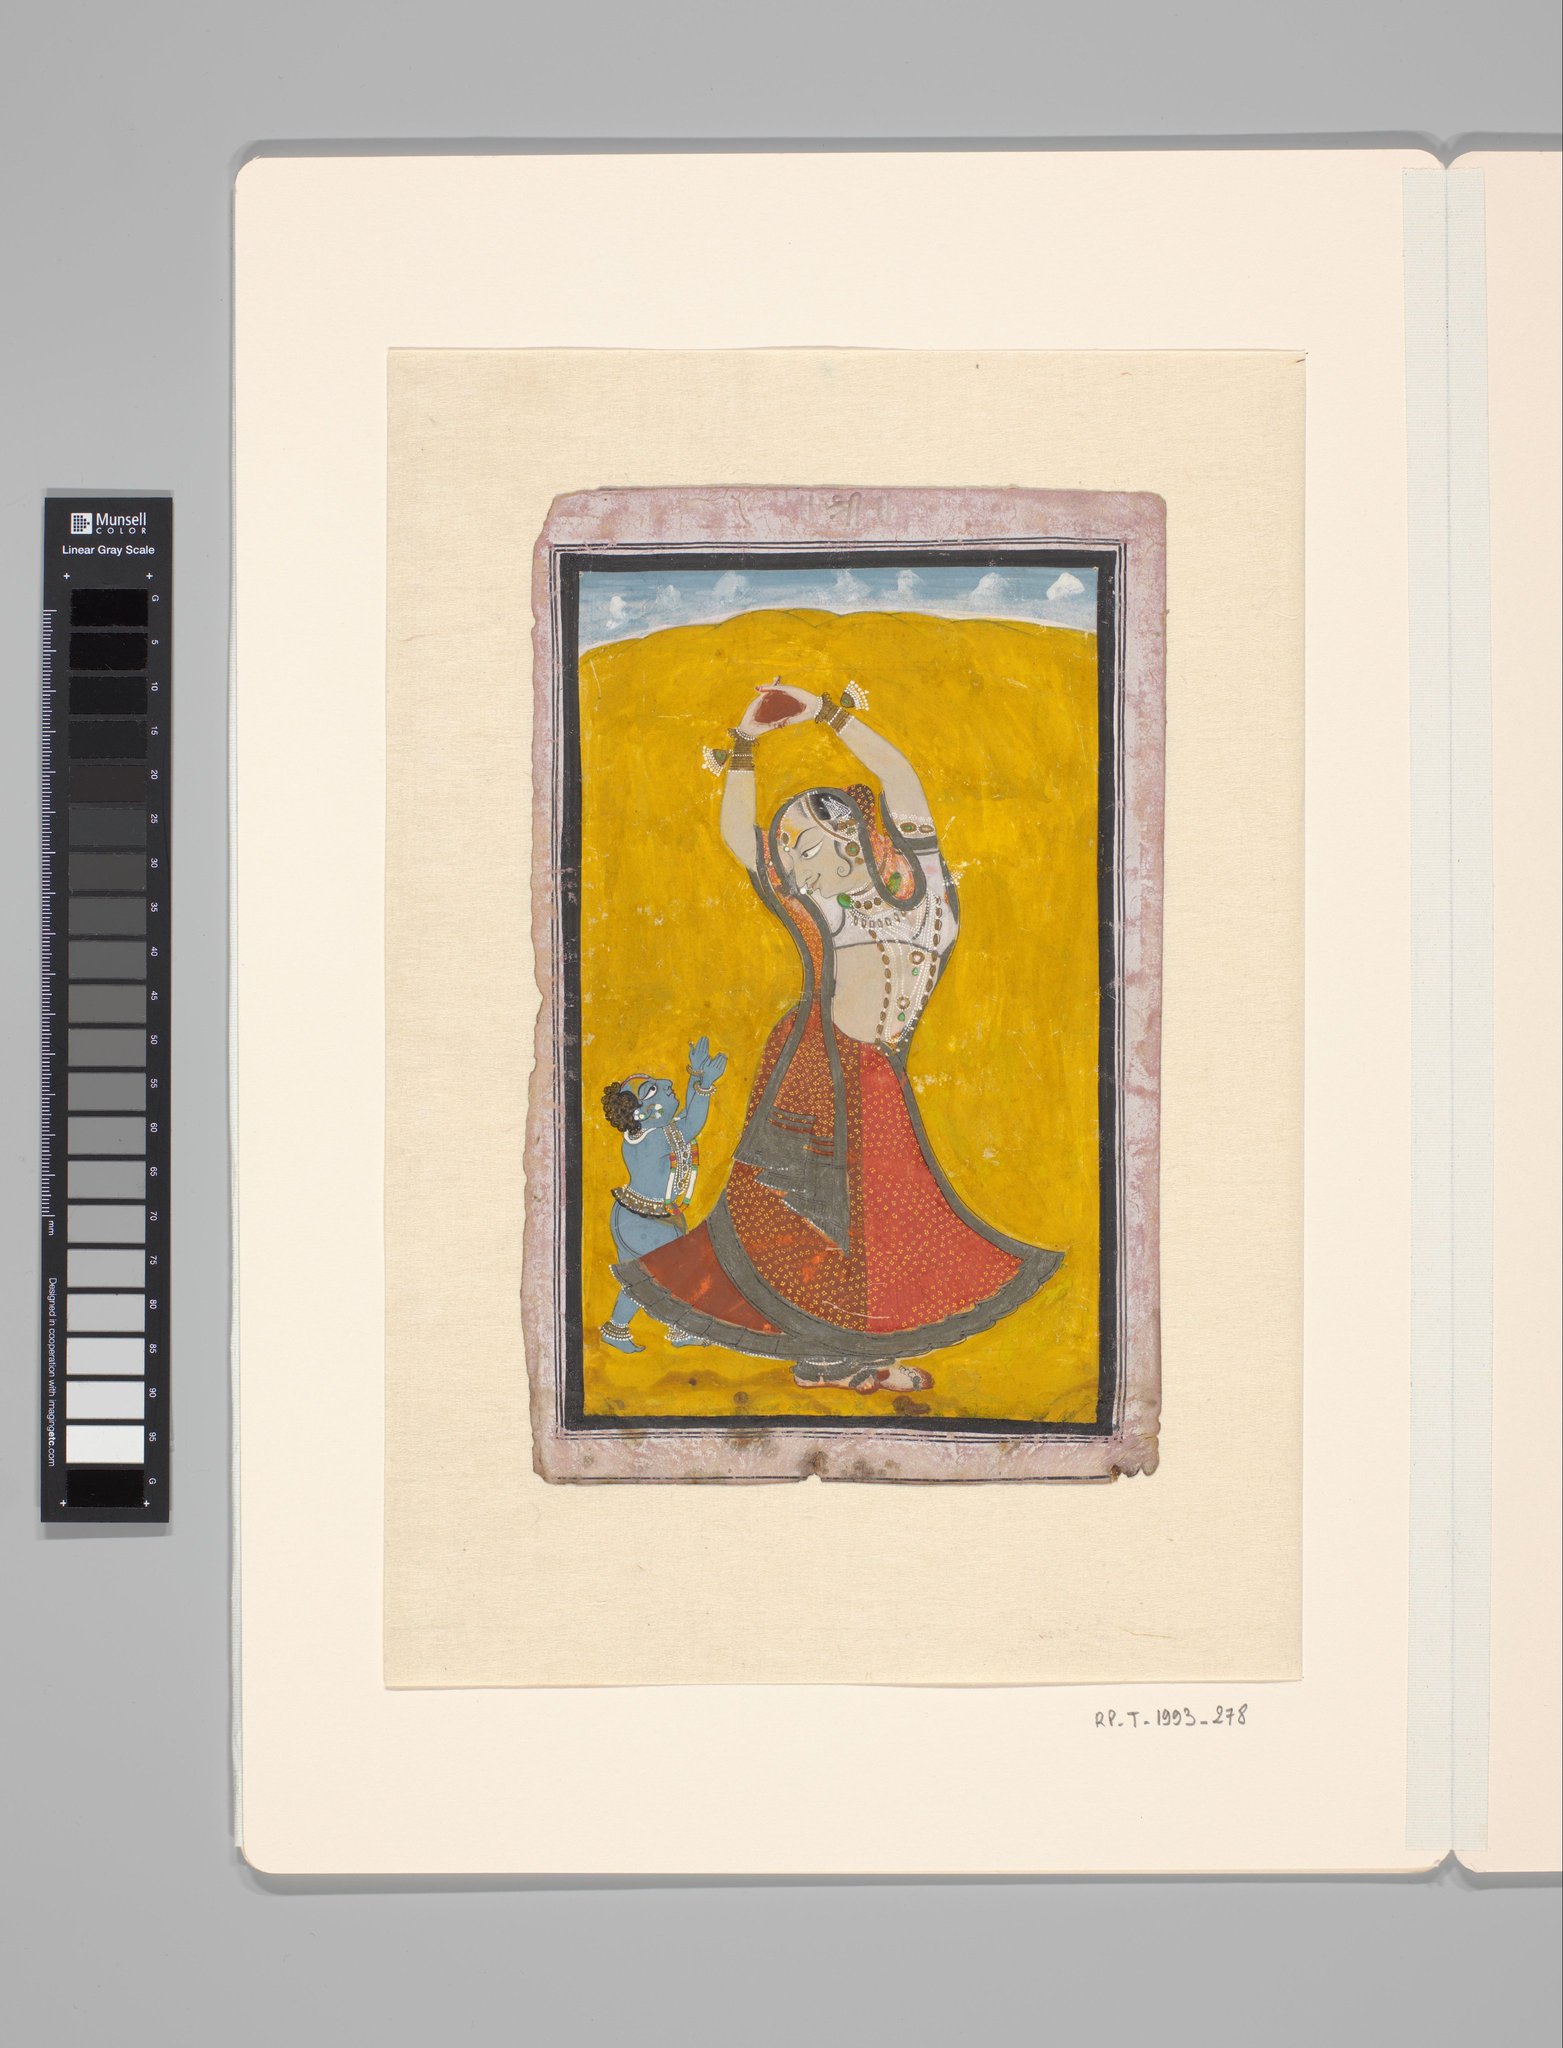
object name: indian miniature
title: A Woman and a Child (Yashoda and Krishna)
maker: Anonymous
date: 1800-1820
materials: paper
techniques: brush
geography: mewar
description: The female figure holds her hands above her head, recalling the pose of longing. The small boy next to her raises his hands in order to be lifted up. This composition occurs frequently in Mewari painting from the 15th century onwards. The boy’s blue-grey skin denotes him as Krishna. This portrayal allows the viewer to perceive the Hindu god as an endearing child deserving of unconditional love.